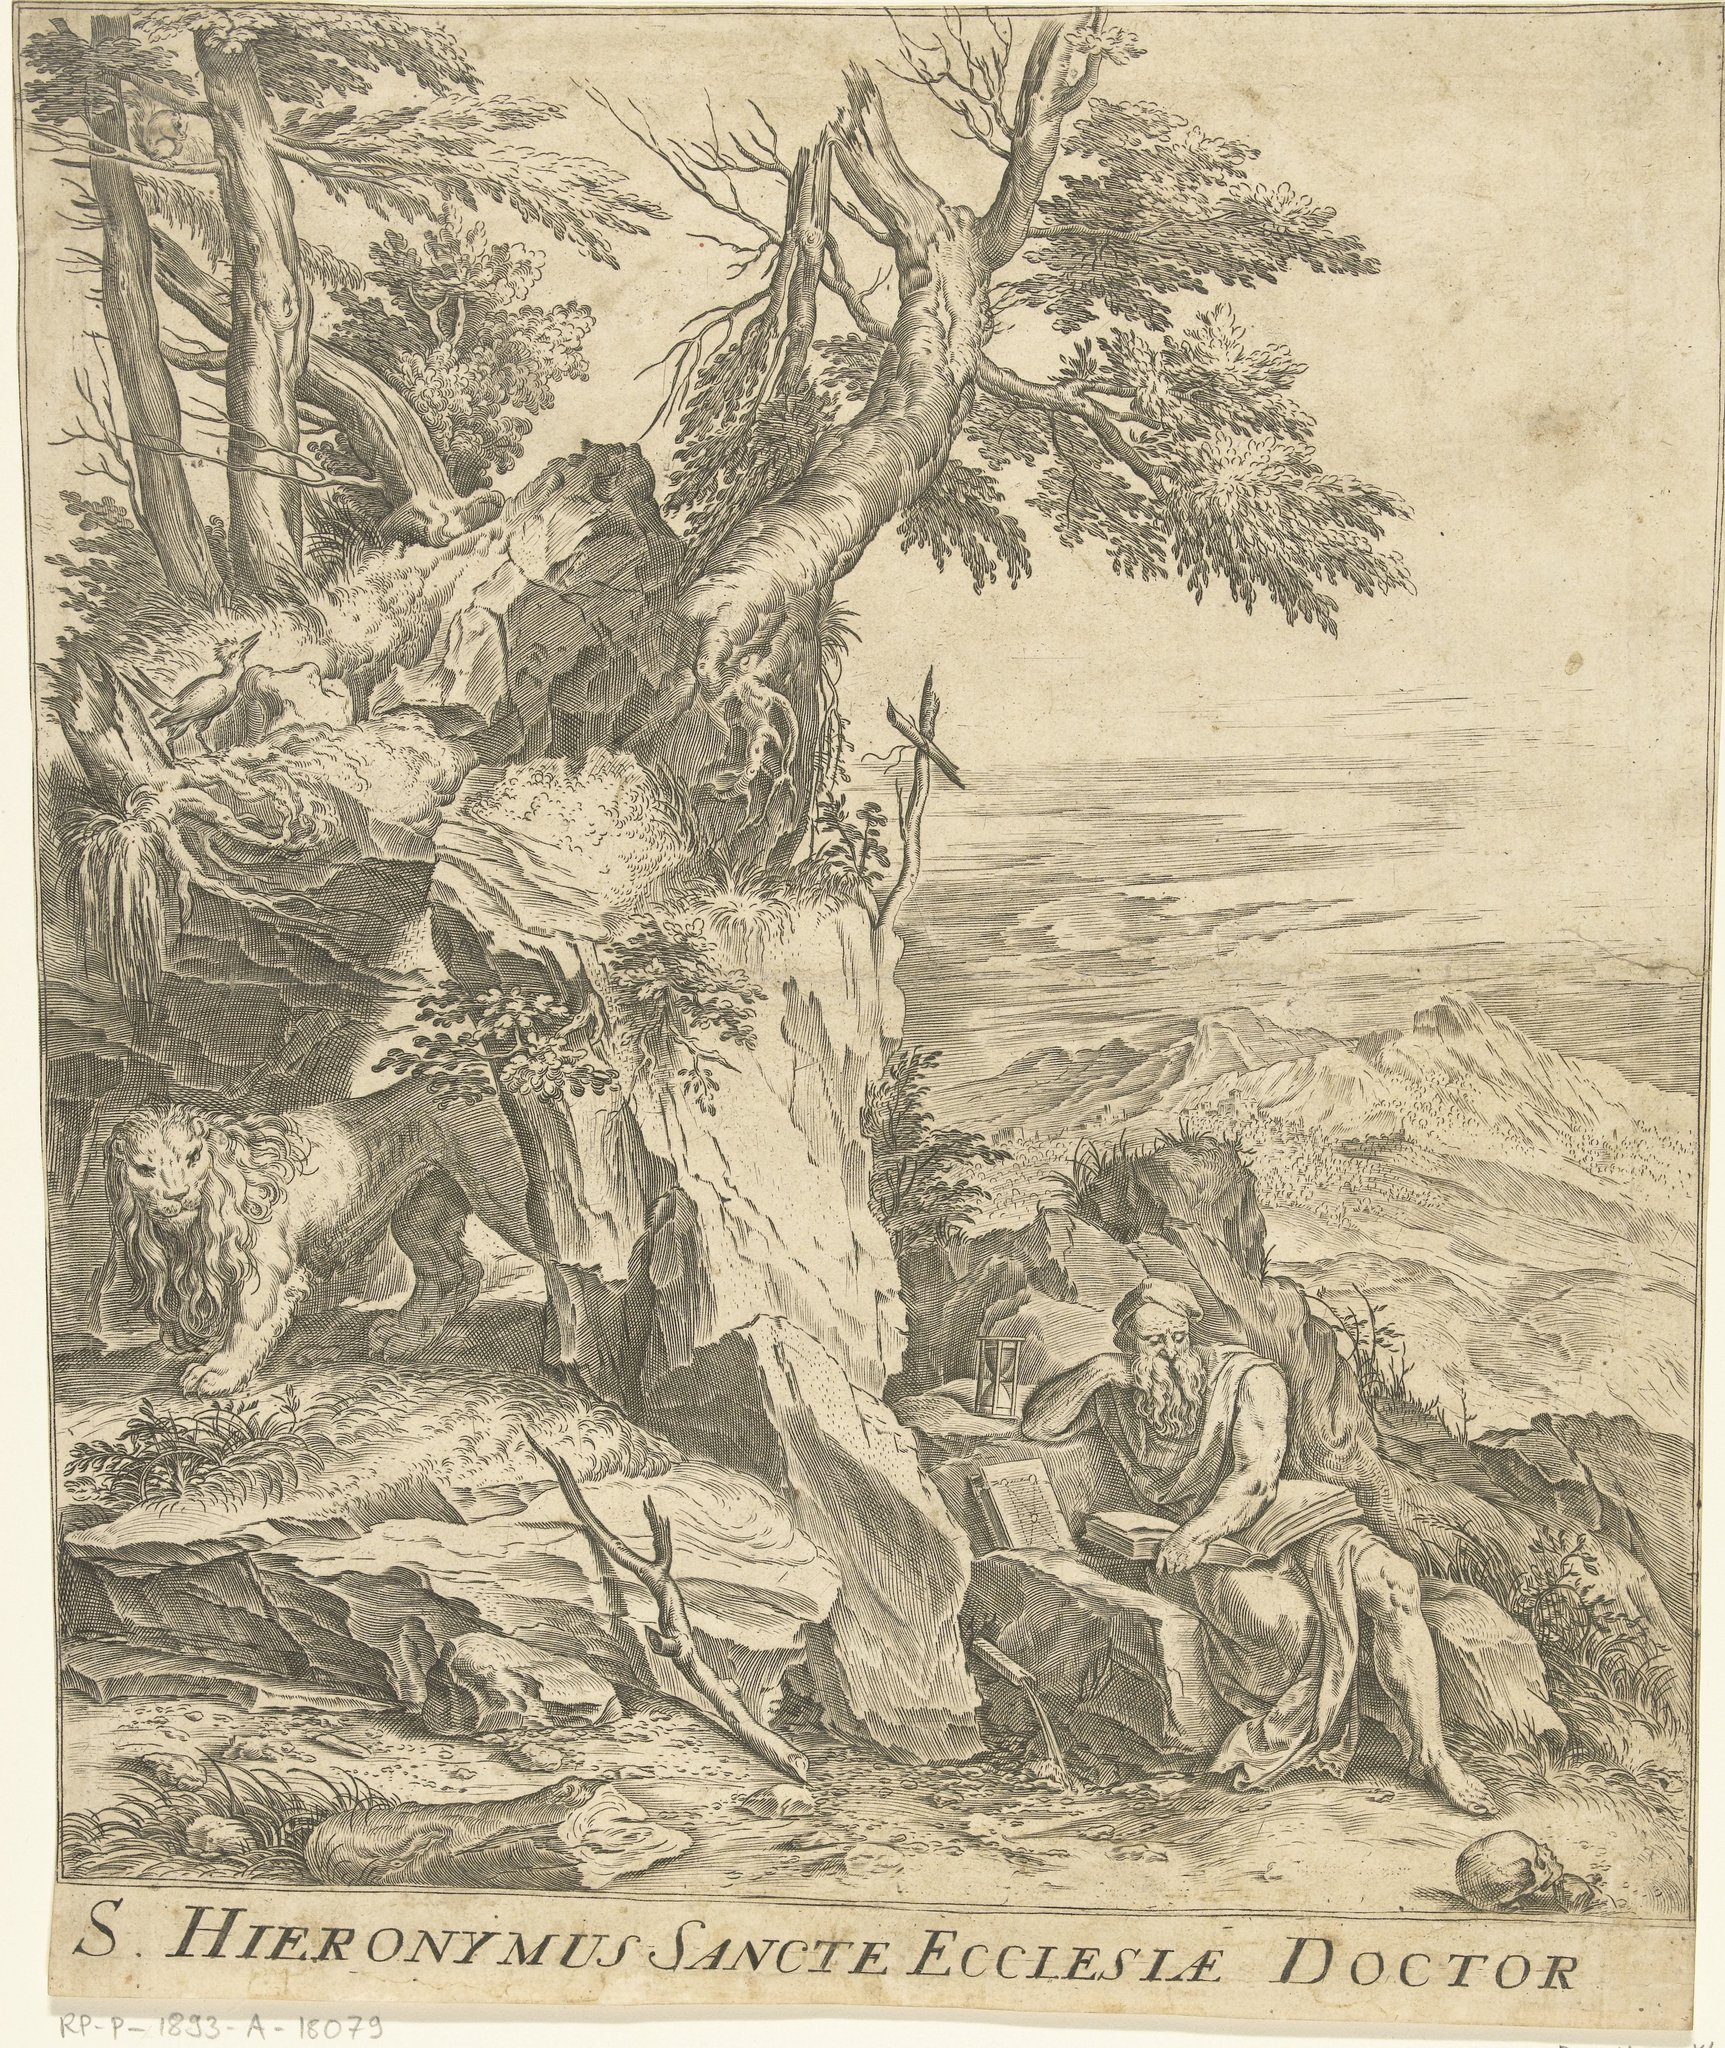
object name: print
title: Landschap met lezende Hieronymus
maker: cornelis cort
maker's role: print maker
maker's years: 1533-1578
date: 1650-1750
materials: paper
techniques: engraving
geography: rome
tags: the monk and hermit jerome (hieronymus); possible attributes: book, cardinal's hat, crucifix, hour-glass, lion, skull, stone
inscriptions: collector's mark: Lugt 2228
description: De heilige Hieronymus zit in een bergachtig landschap op een rots te lezen. Naast hem een boek en een zandloper. De leeuw, zijn attribuut, struint tussen de rotsen.